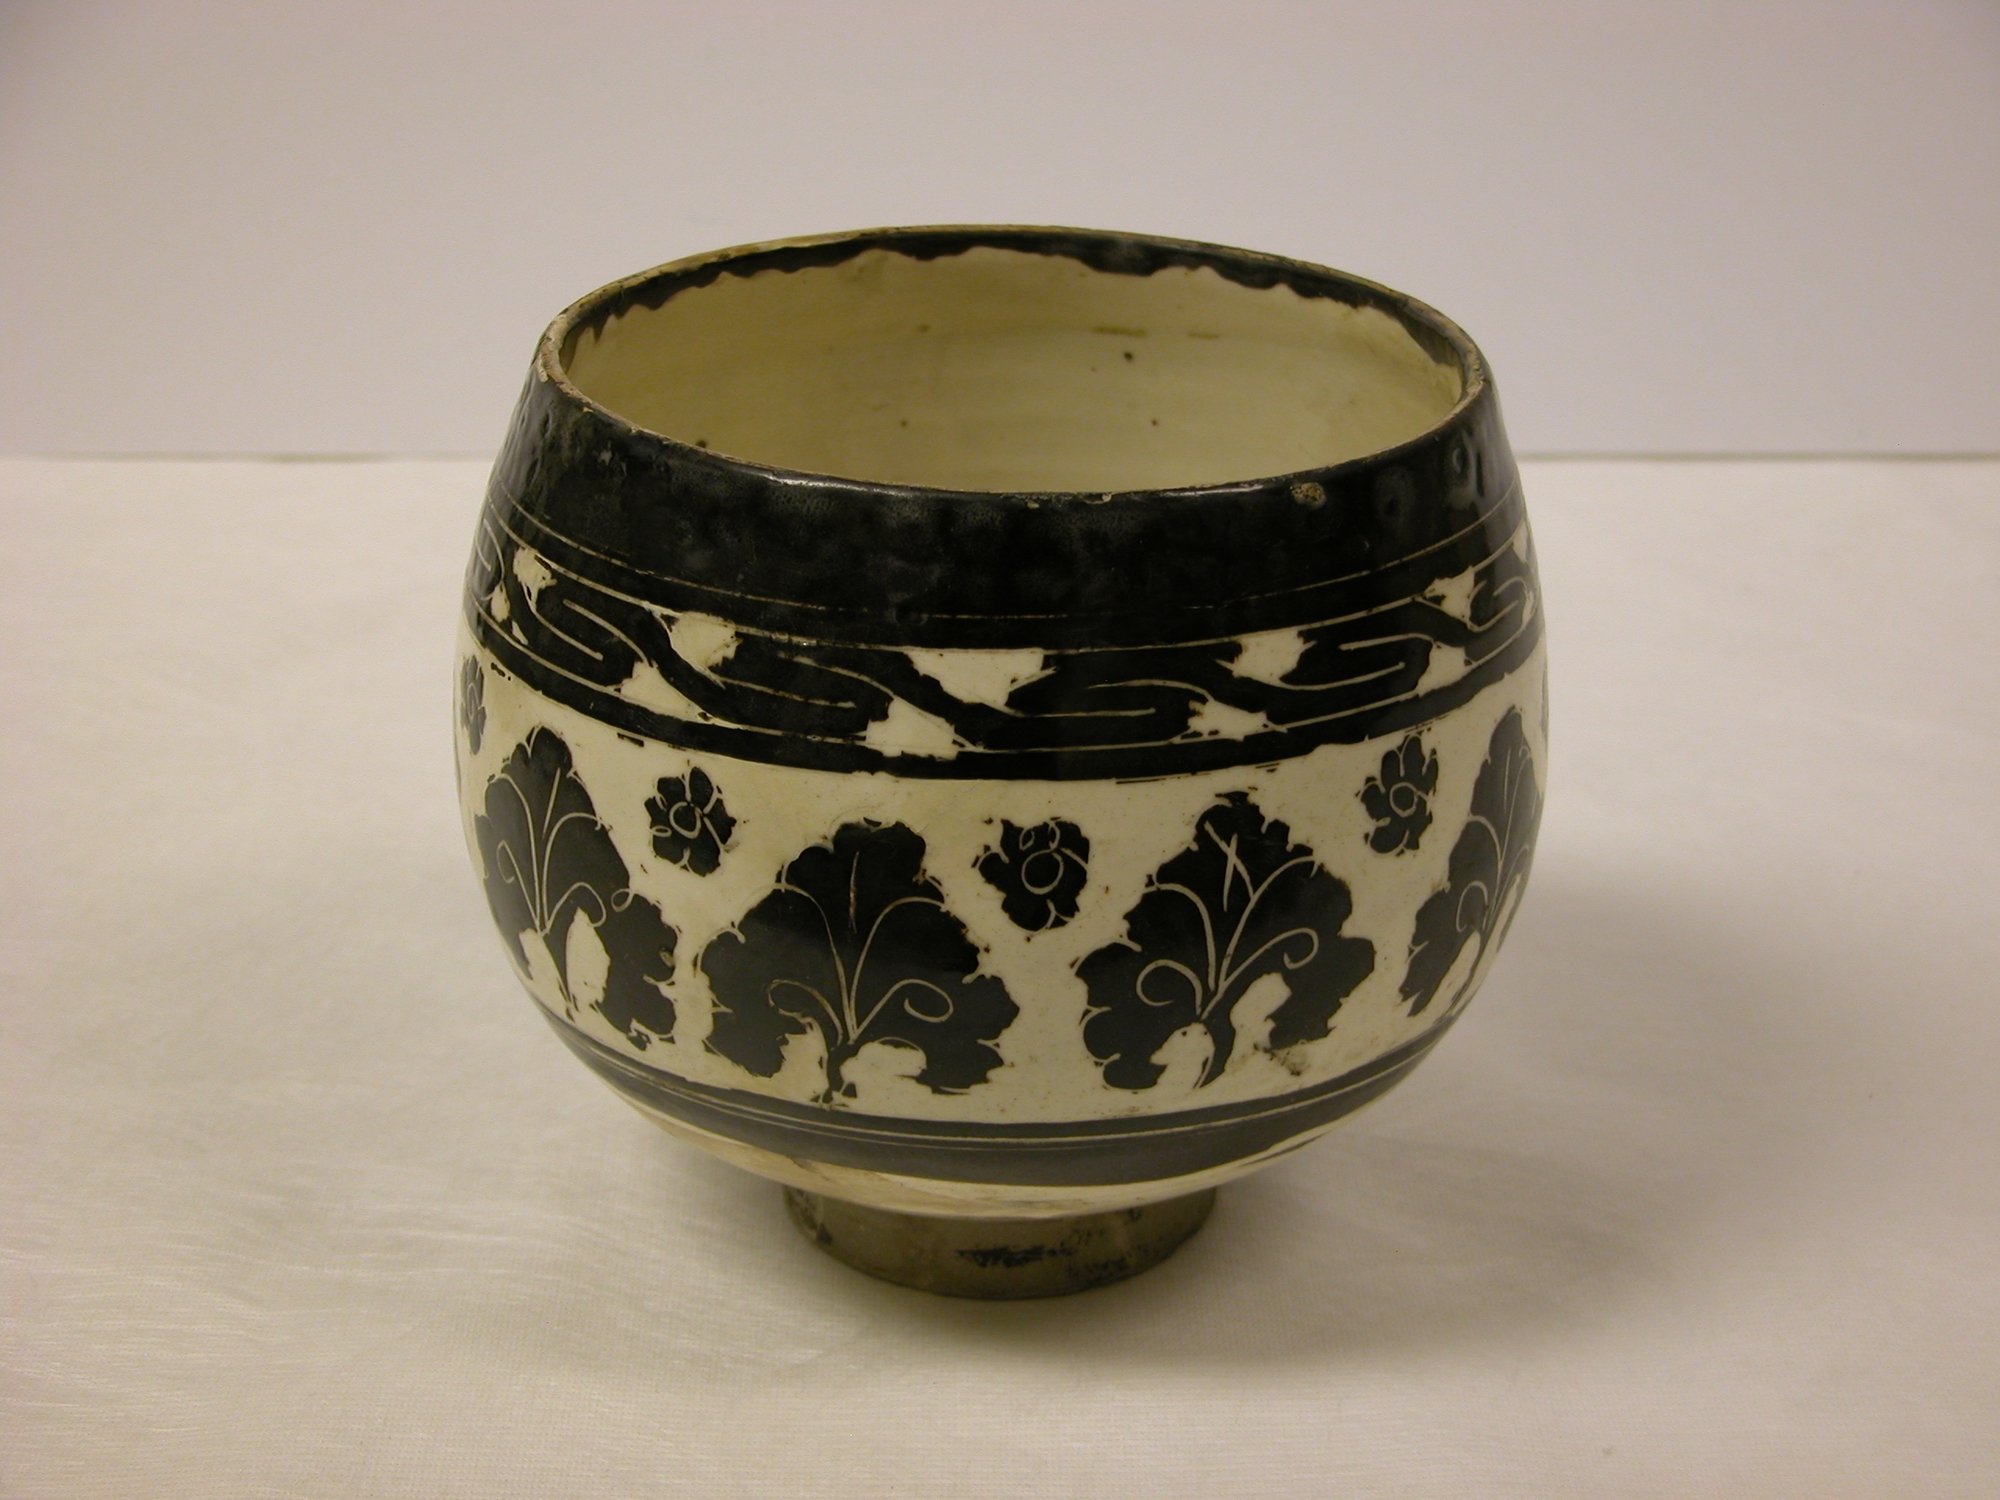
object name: bowl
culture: chinese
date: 960-1279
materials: pottery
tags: leaves